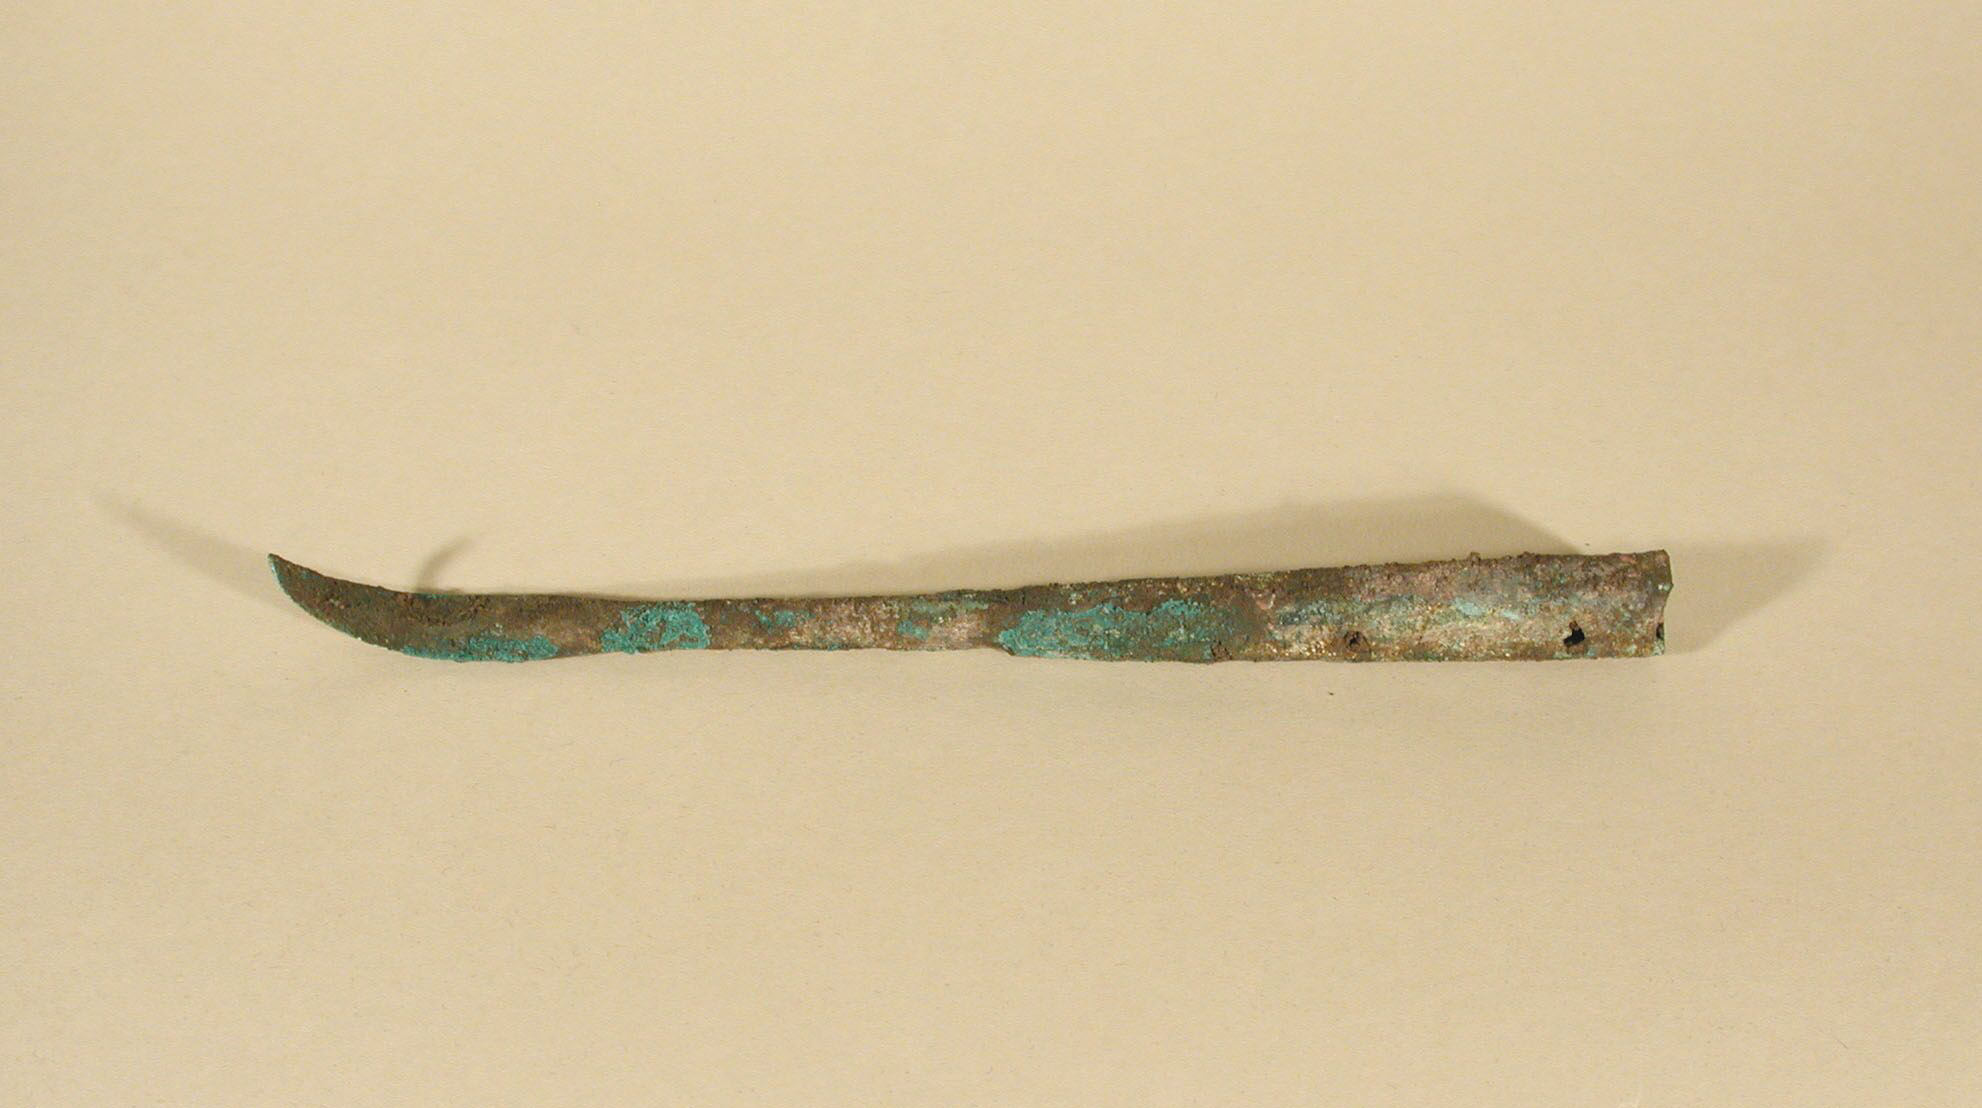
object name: knife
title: Curved Blade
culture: chinese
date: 1000-1 BCE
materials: bronze